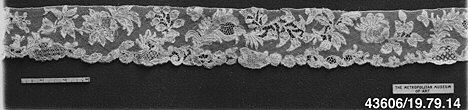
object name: strip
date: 1701-1733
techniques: lace